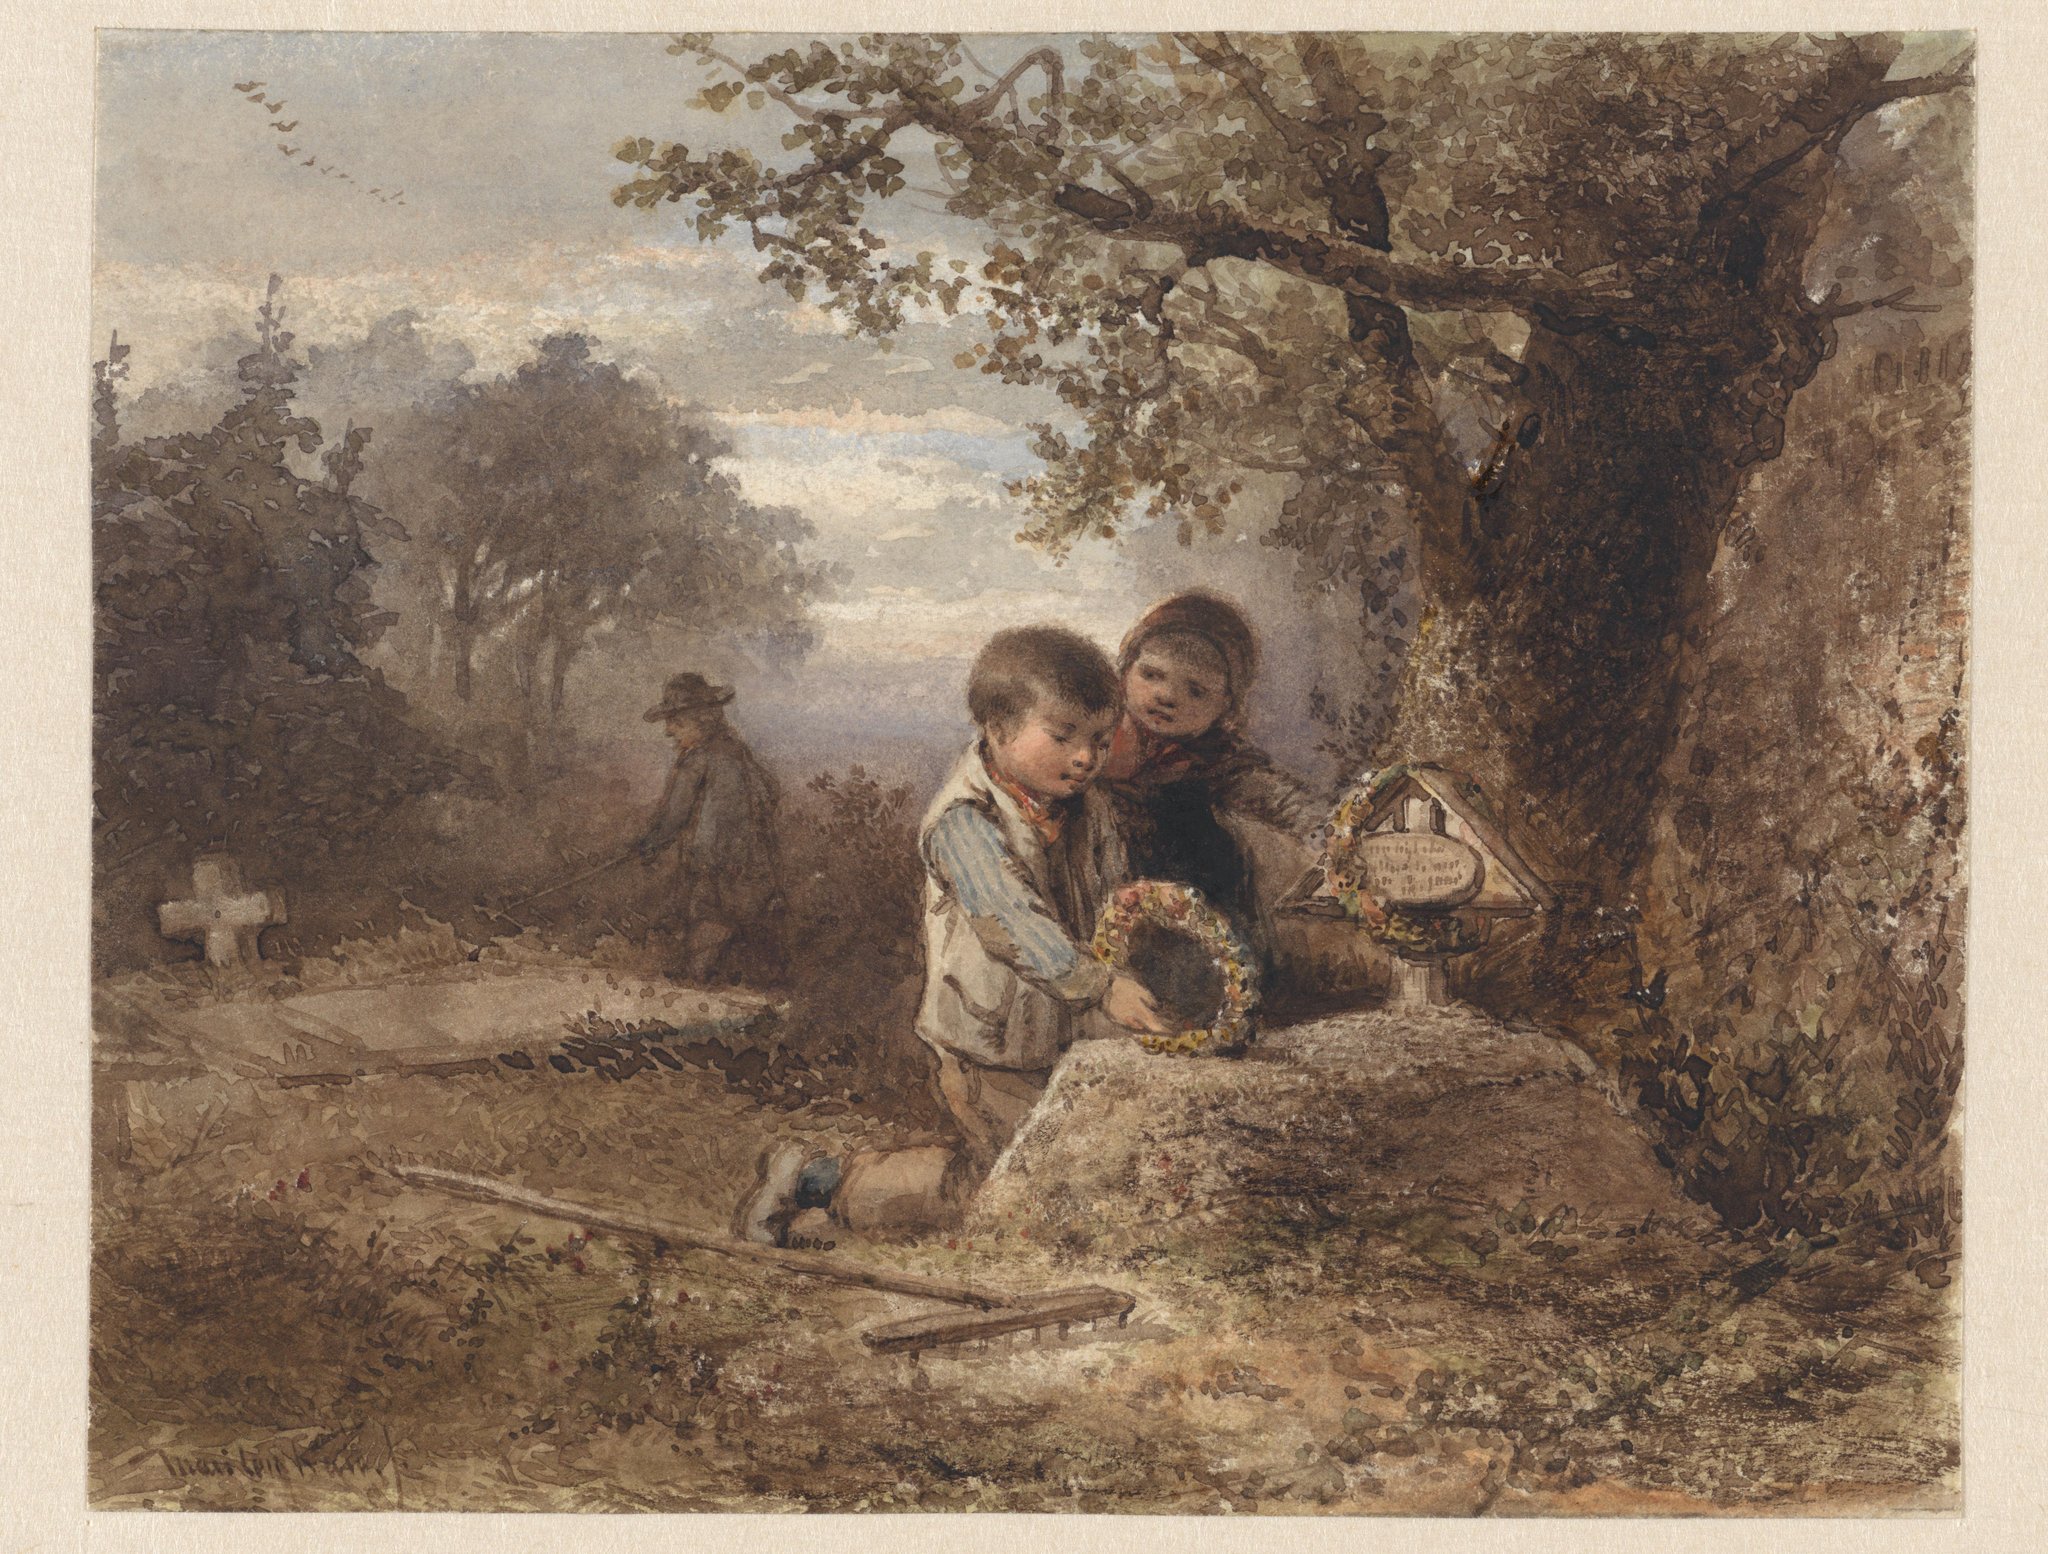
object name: drawing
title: Twee kinderen bij een graf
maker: mari ten kate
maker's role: draughtsman, painter, print maker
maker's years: 1831-1910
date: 1841-1910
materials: ink, paper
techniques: brush, pen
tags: laying flowers or wreath on grave